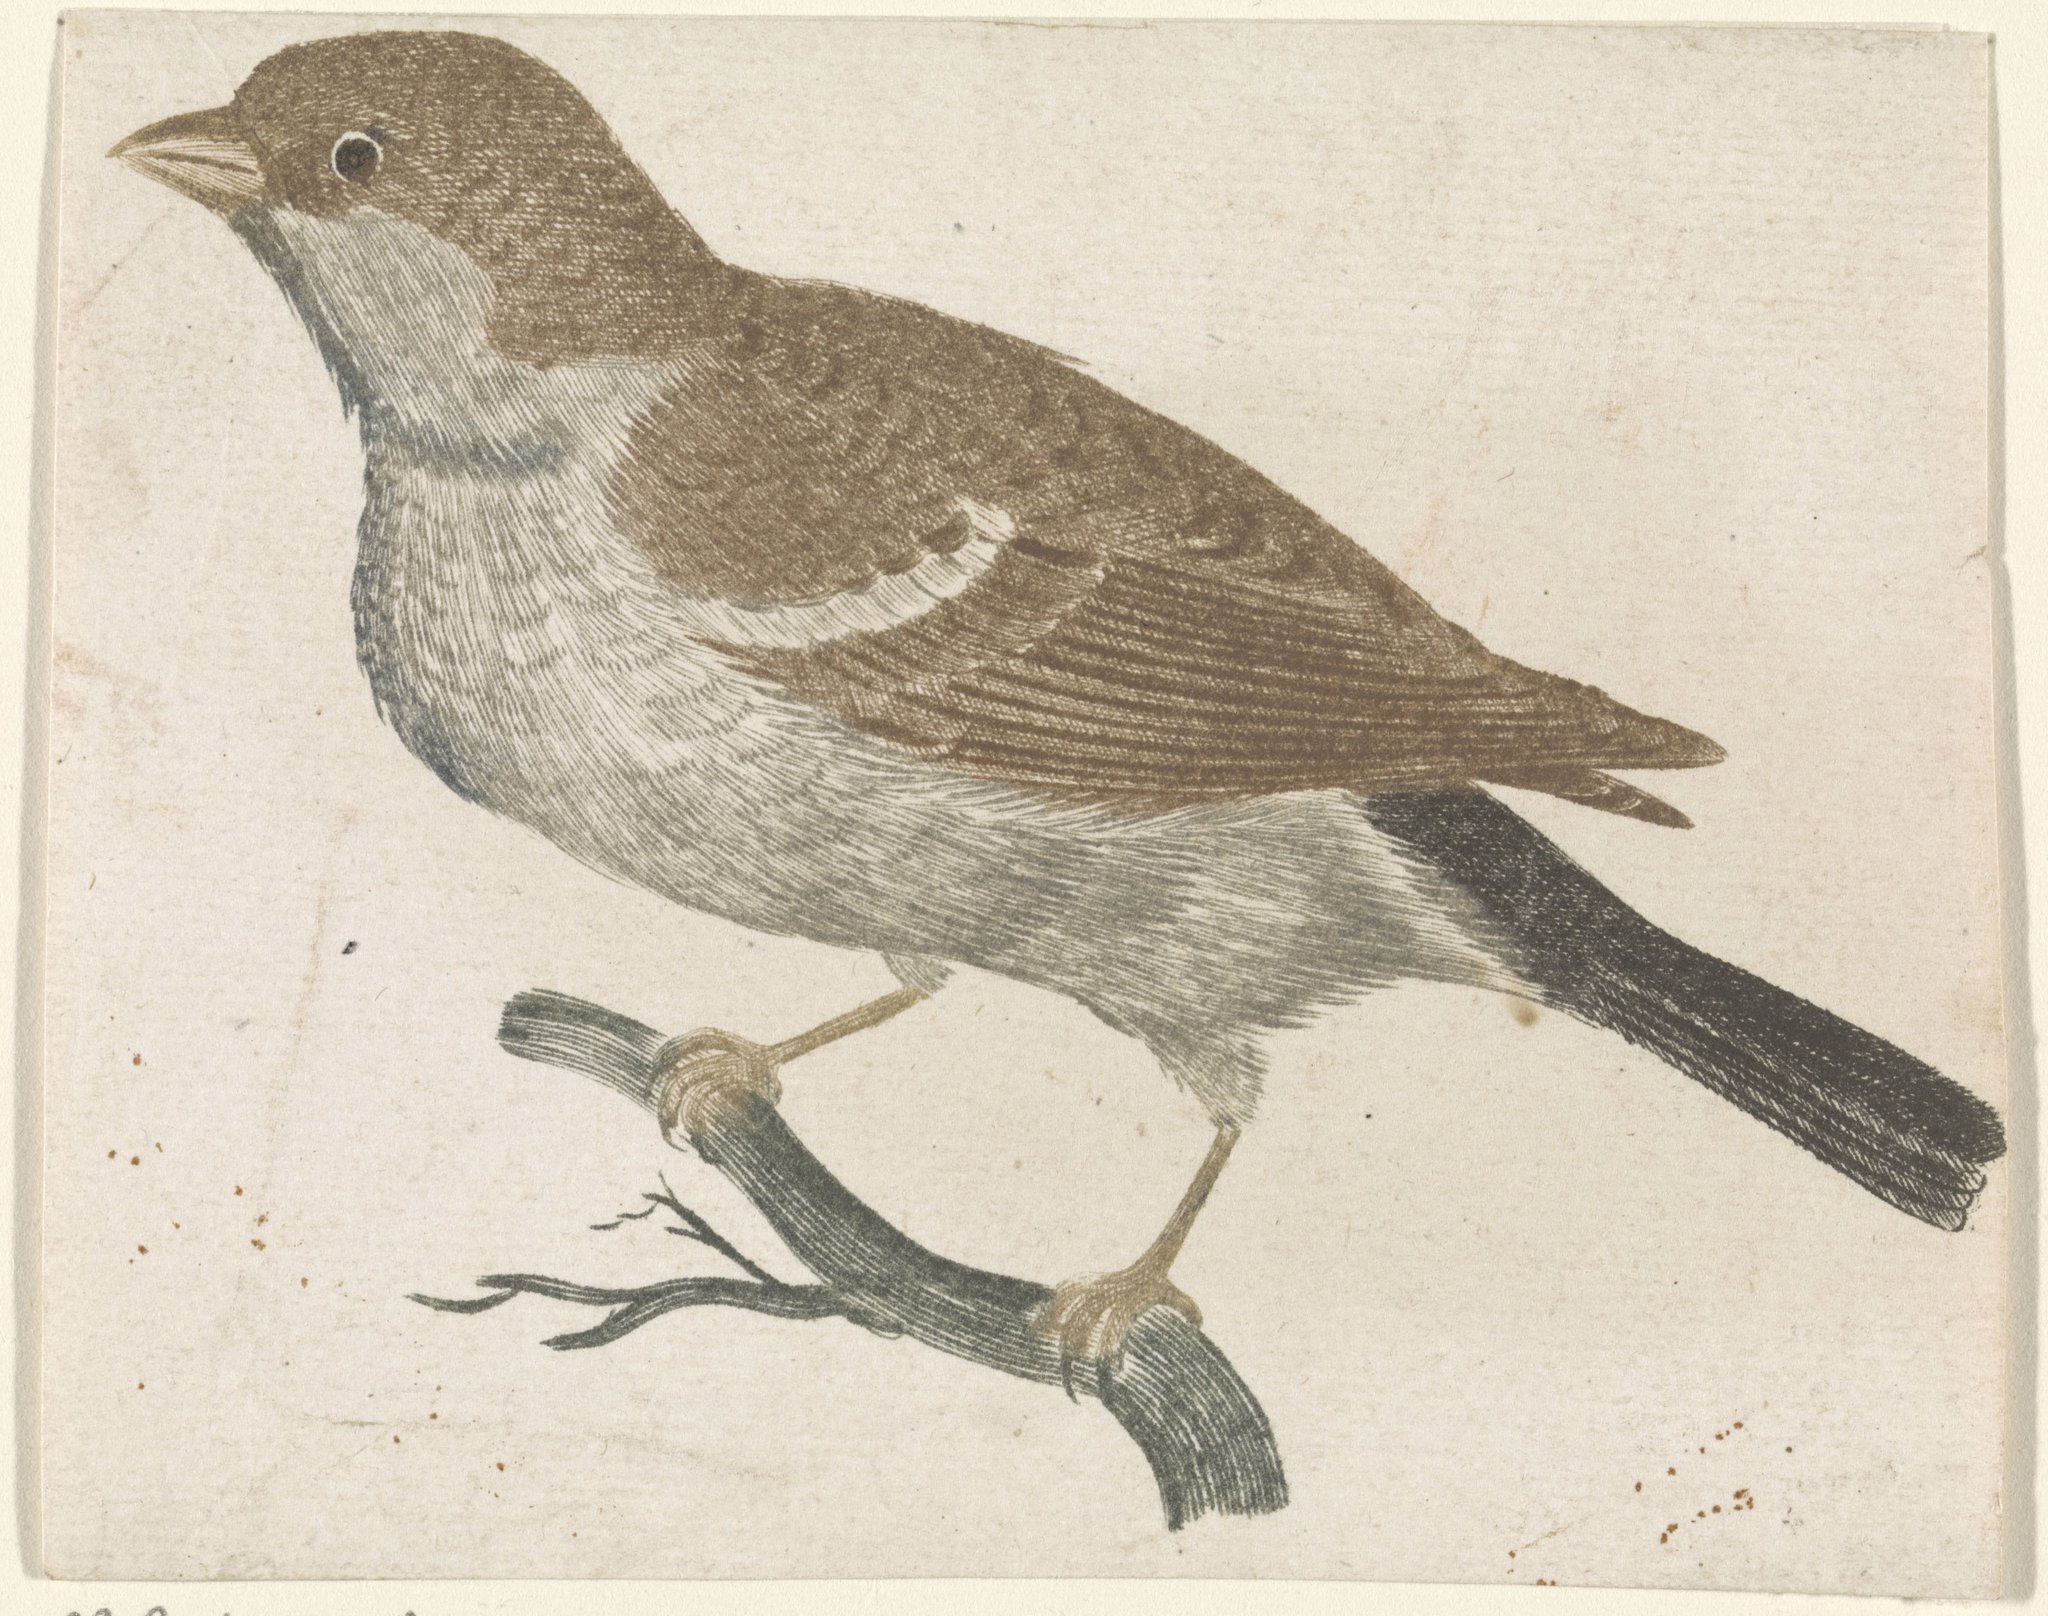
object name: print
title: Mus op een tak naar links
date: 1688-1698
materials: paper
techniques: printing, engraving, lithography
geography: netherlands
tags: song-birds: sparrow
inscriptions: collector's mark: Lugt 2228